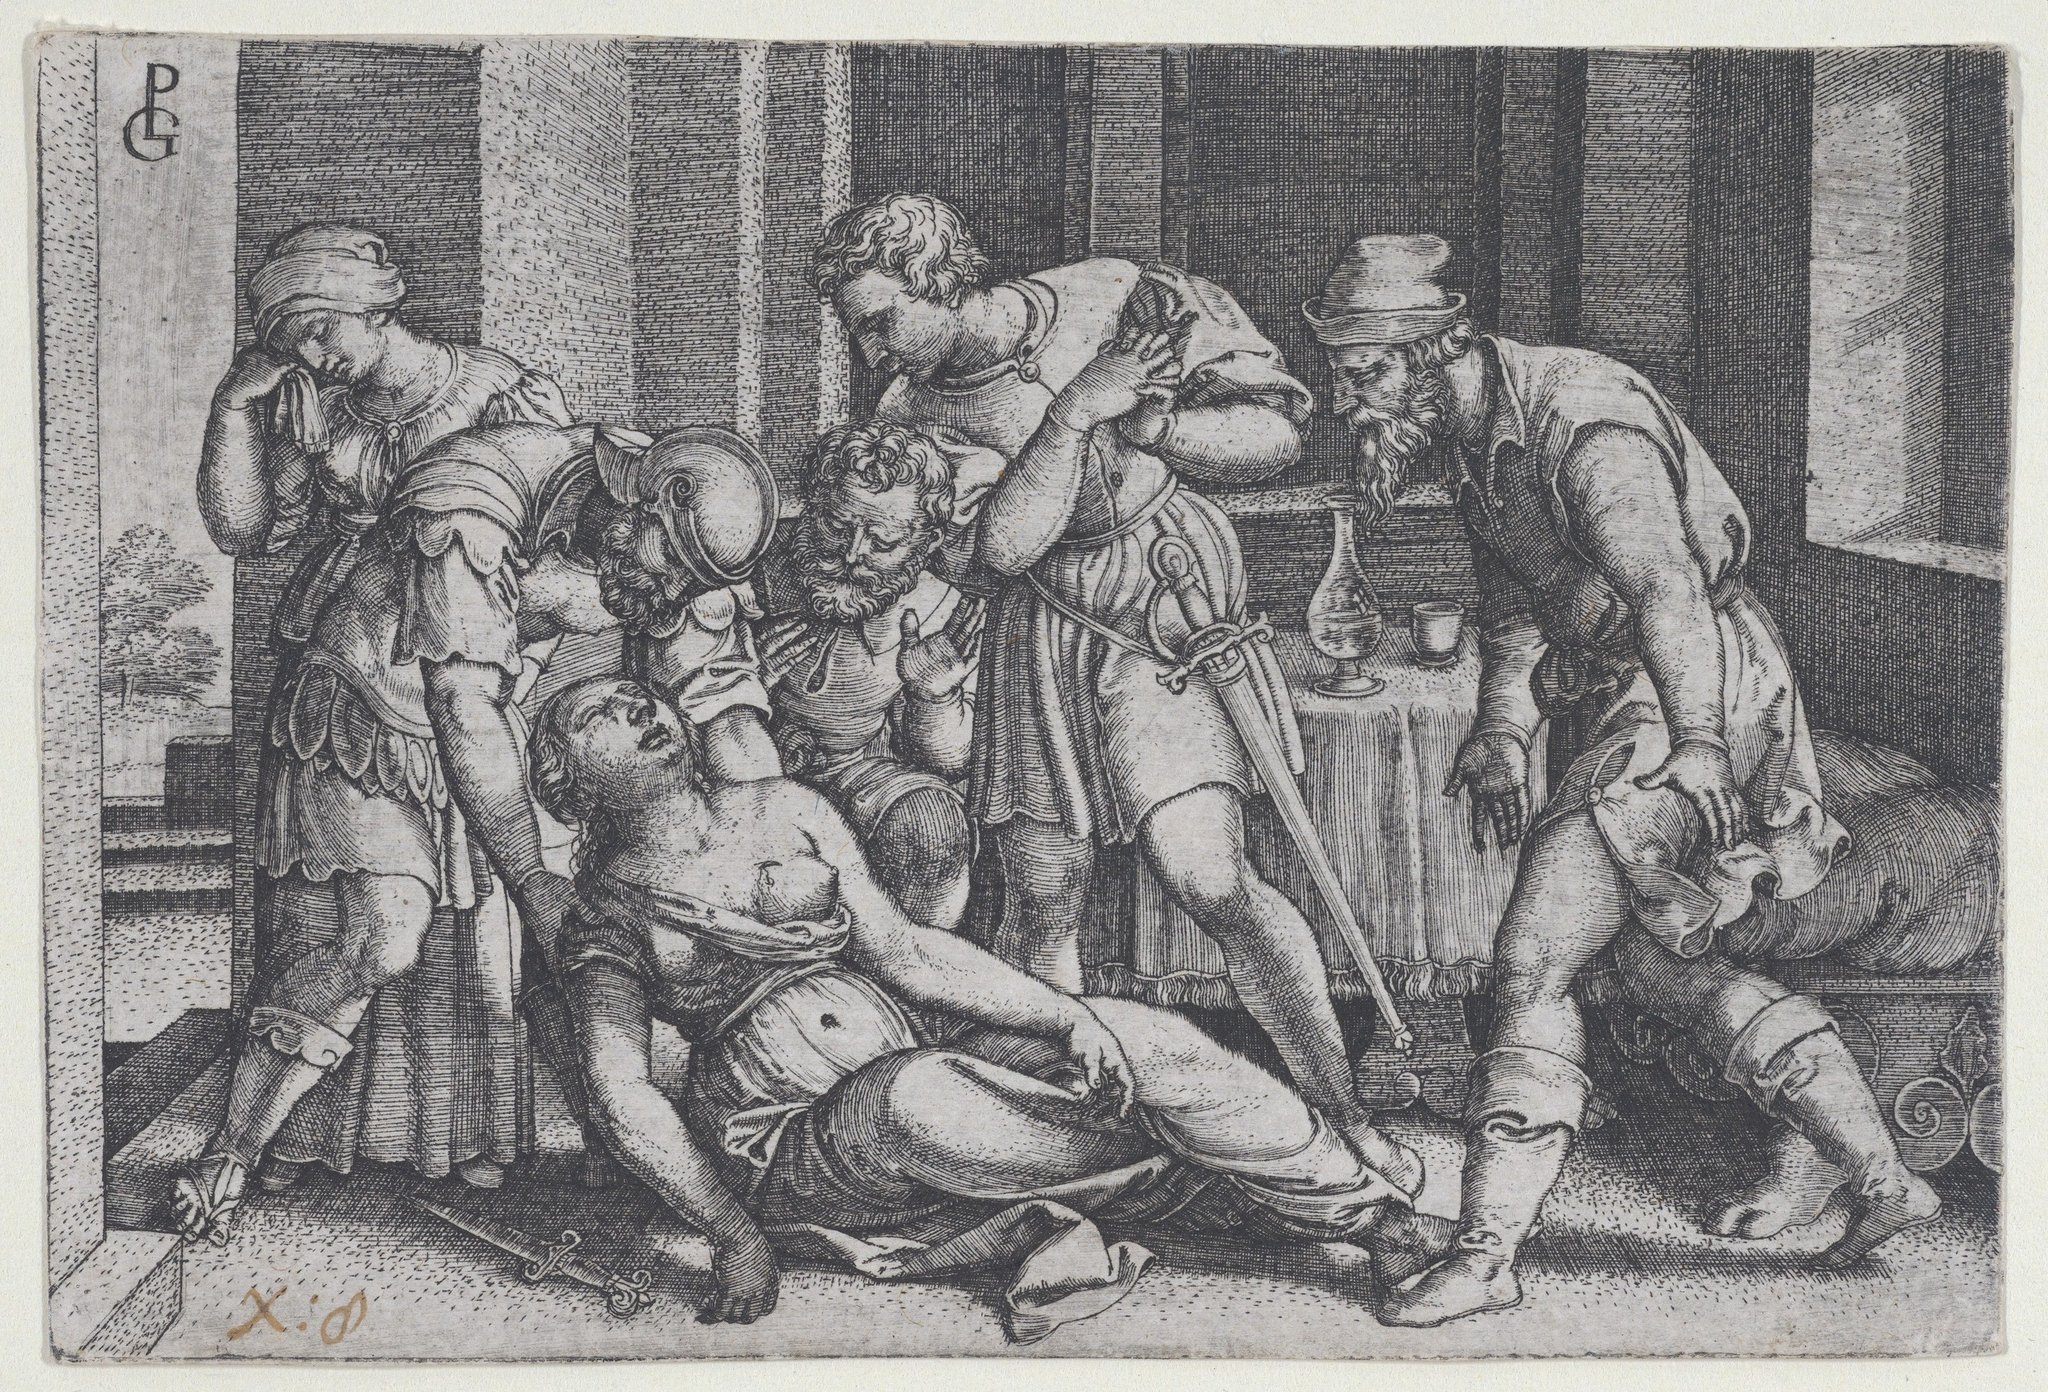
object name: print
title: Suicide of Lucretia, from "Scenes from Roman History"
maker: georg pencz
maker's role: artist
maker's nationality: german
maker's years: 1500-1550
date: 1541-1552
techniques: engraving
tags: men,women,death